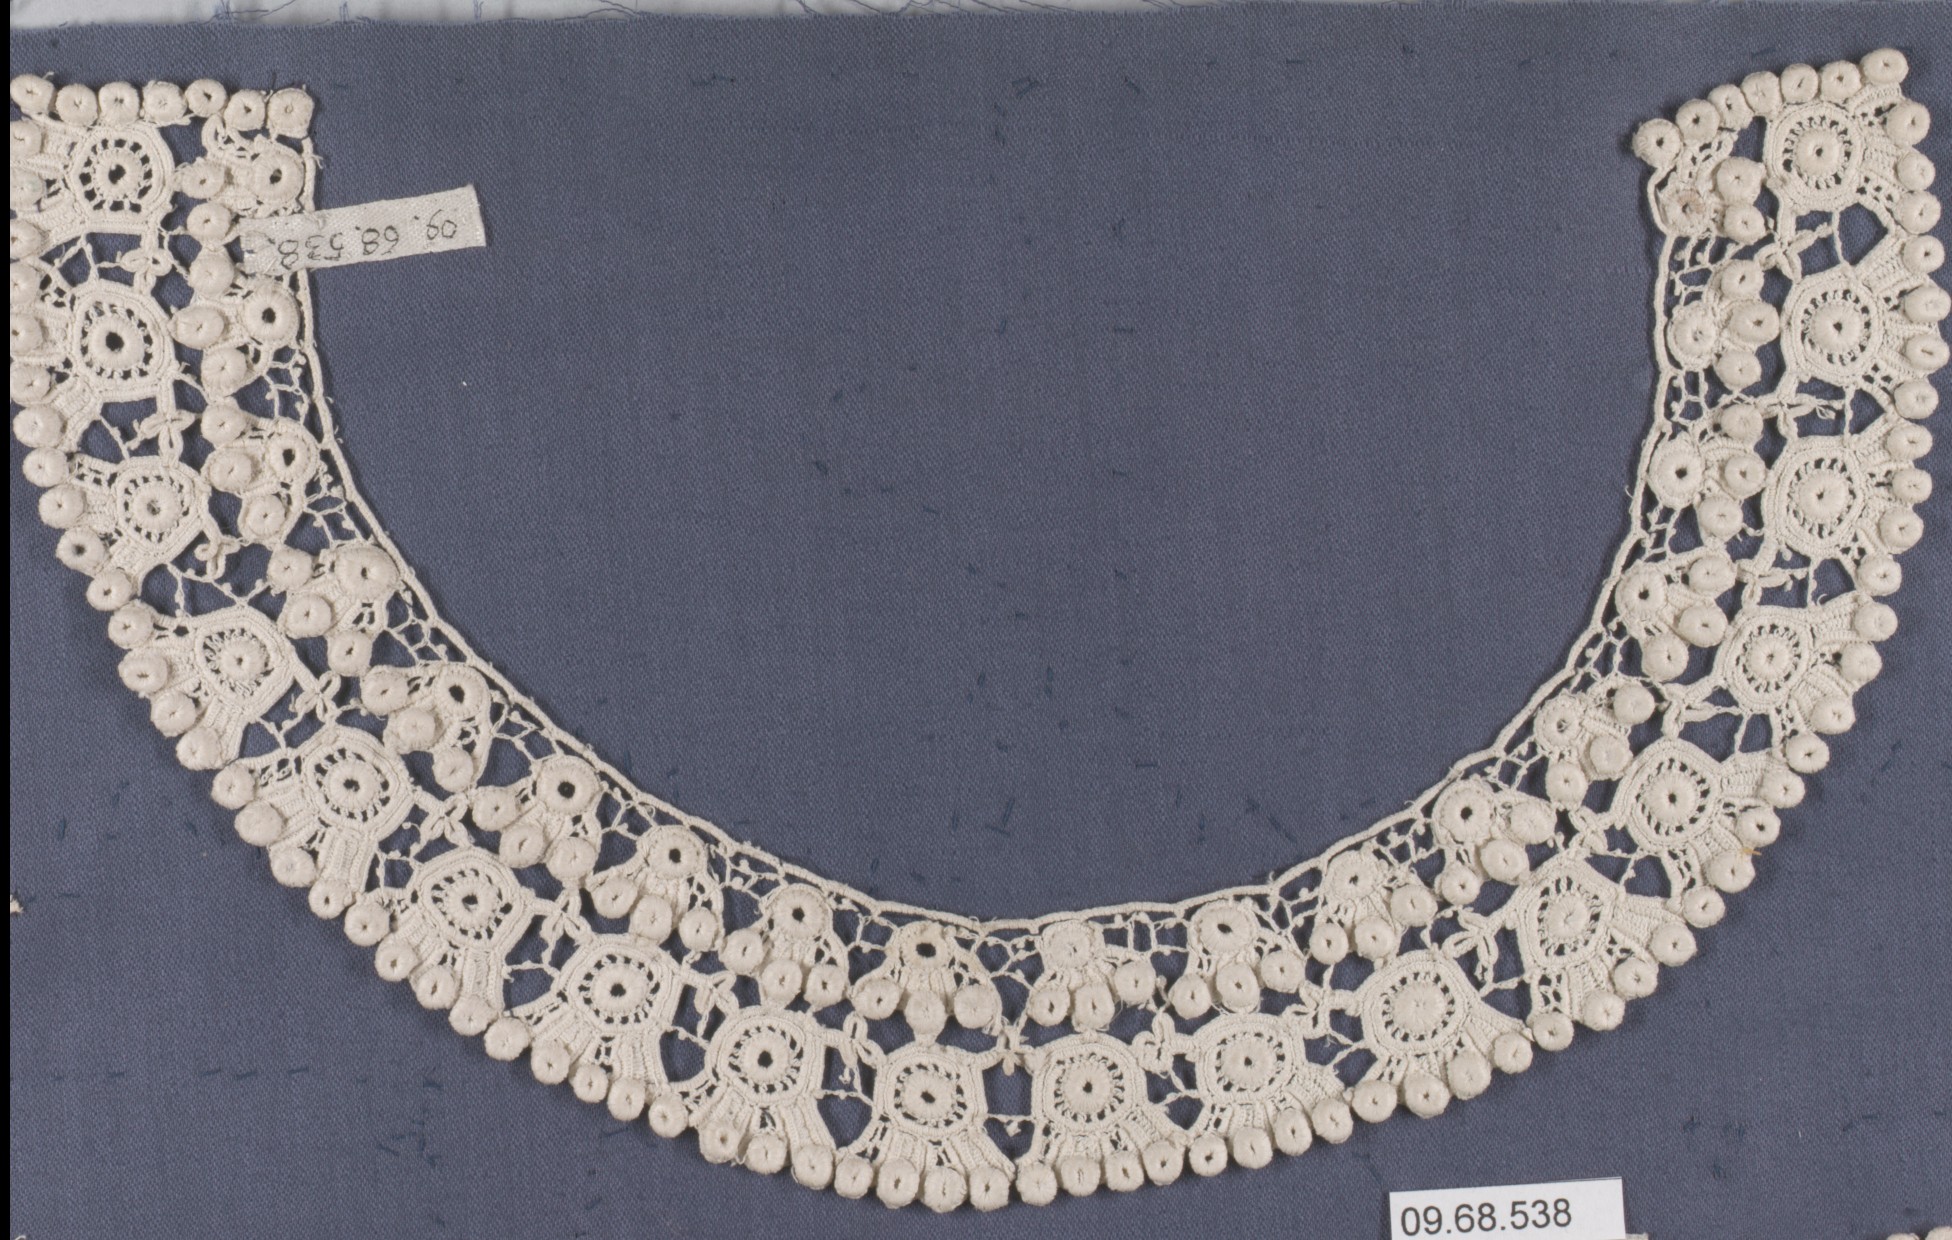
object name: collar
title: Collar lace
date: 1801-1900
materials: lace